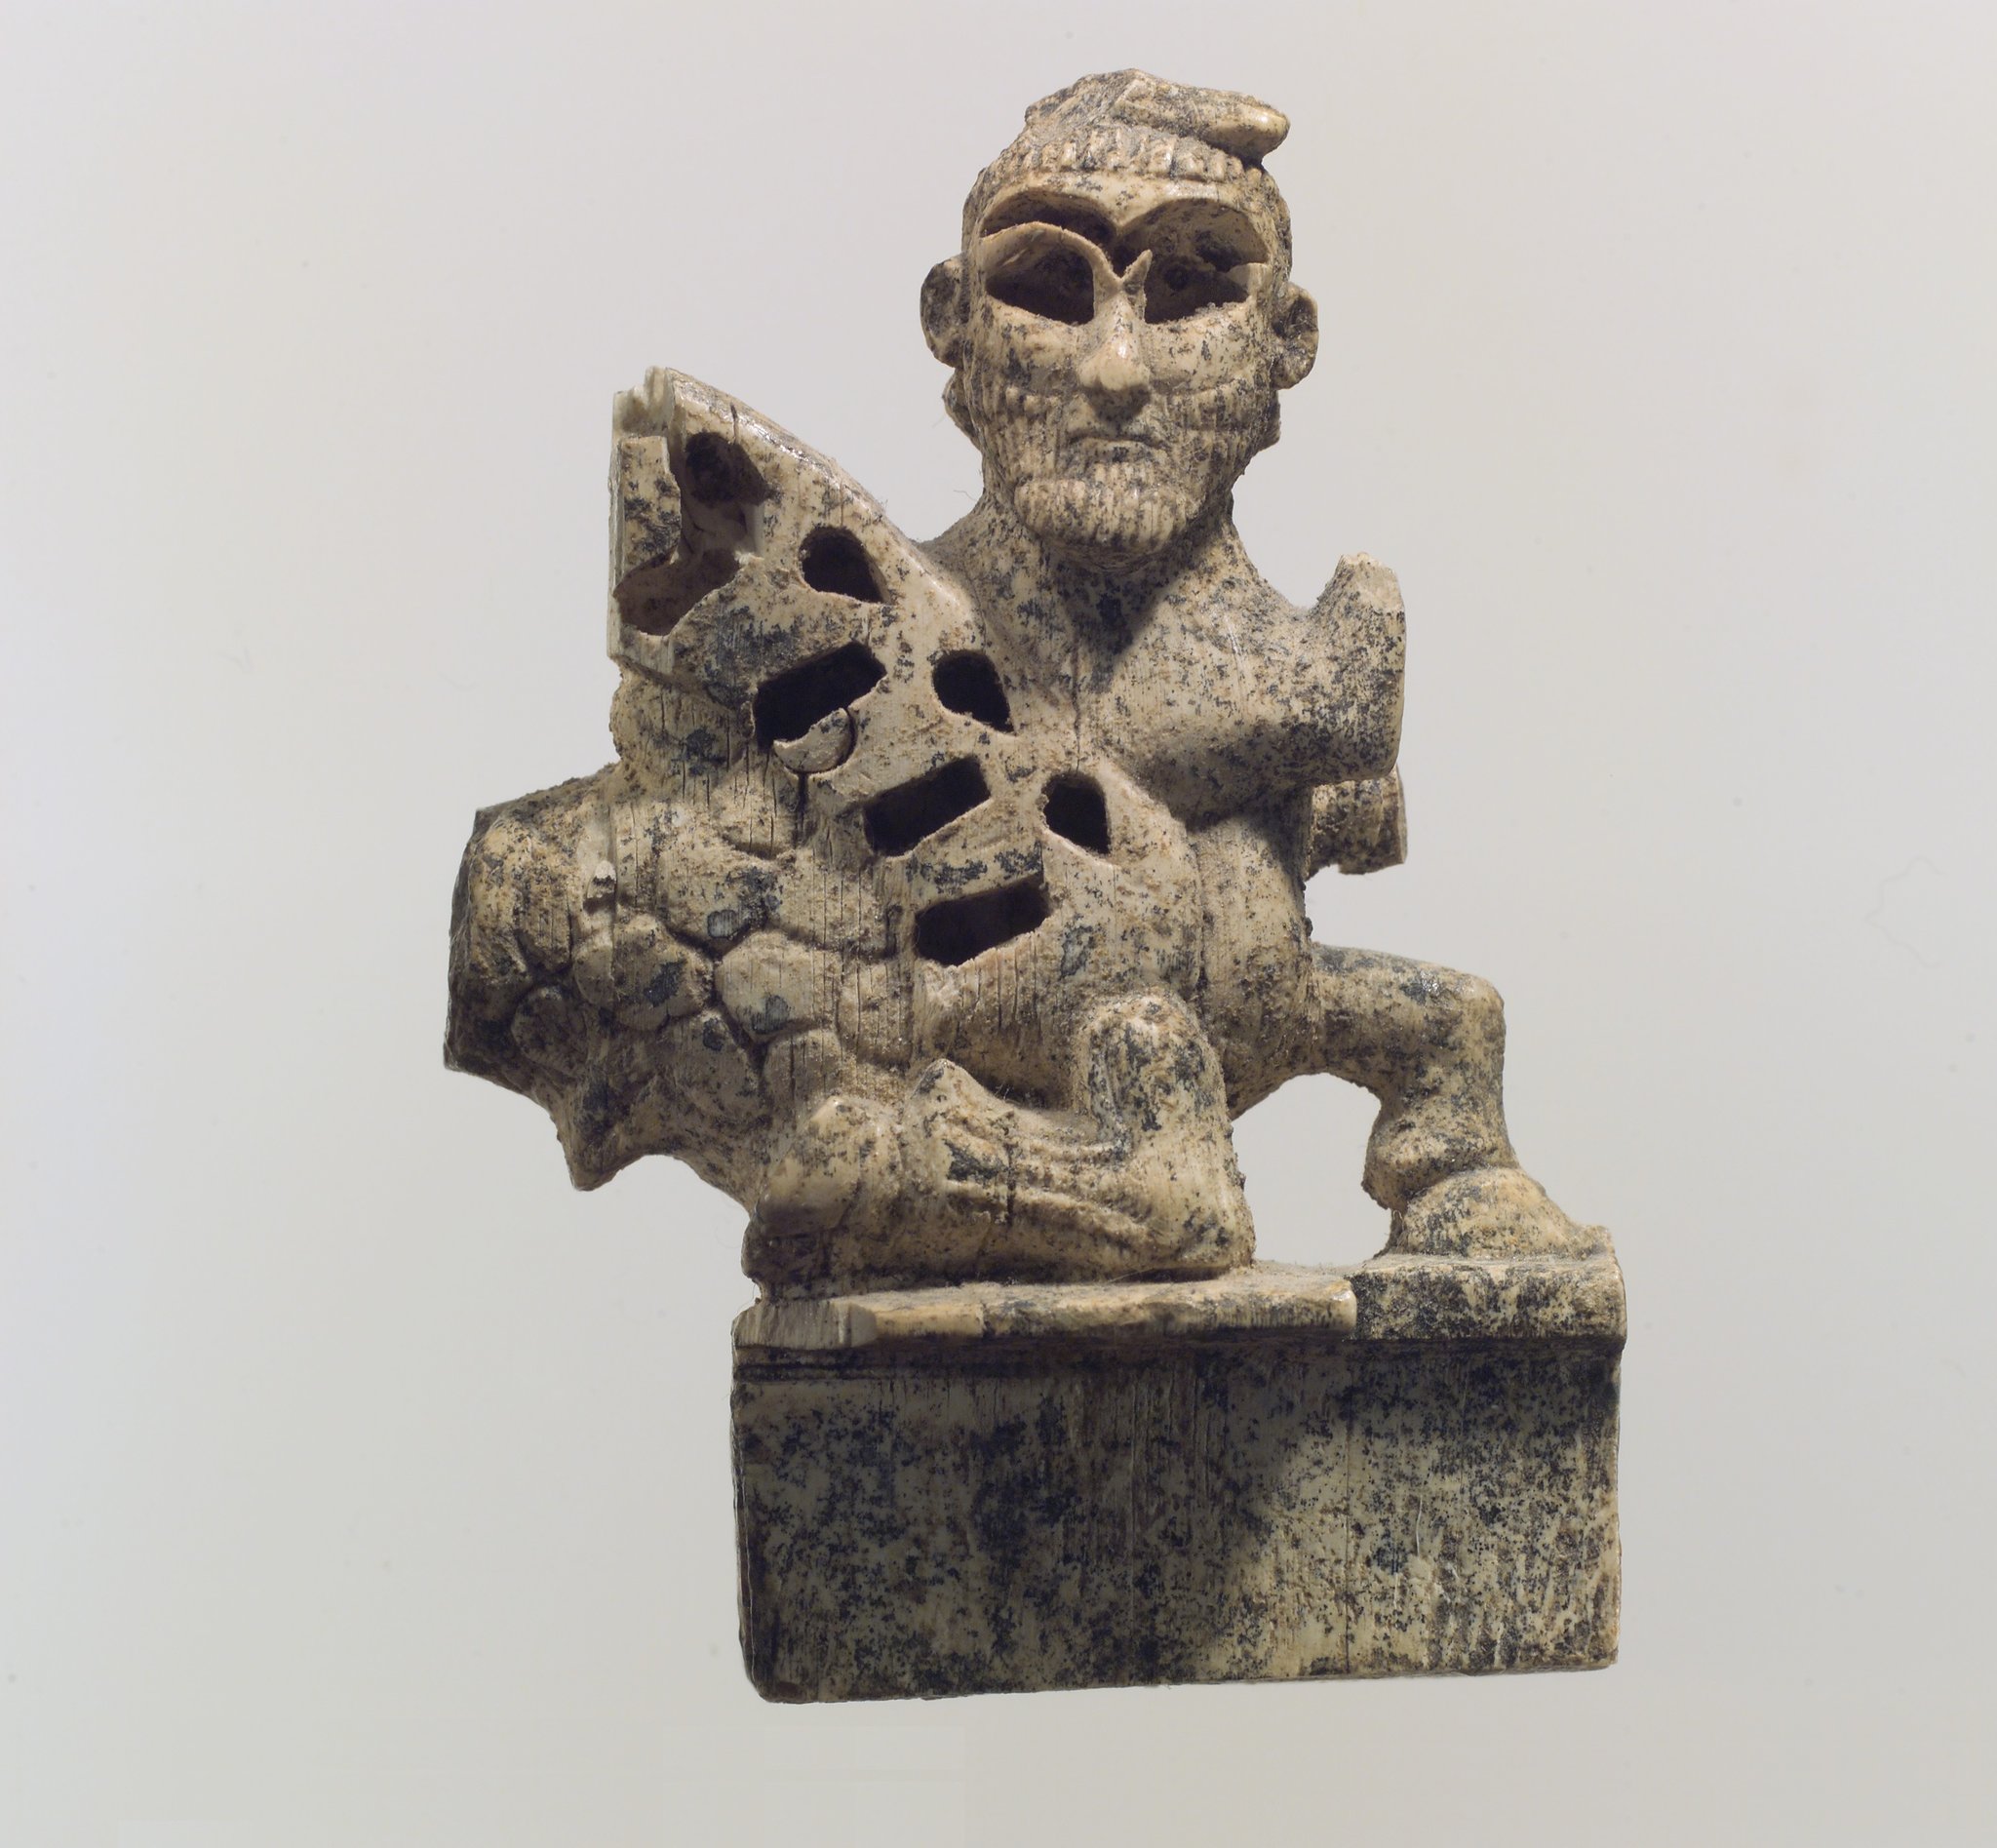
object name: sculpture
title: Figure of a supernatural creature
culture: iranian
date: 800-601 BCE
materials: ivory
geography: iran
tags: mythical creatures